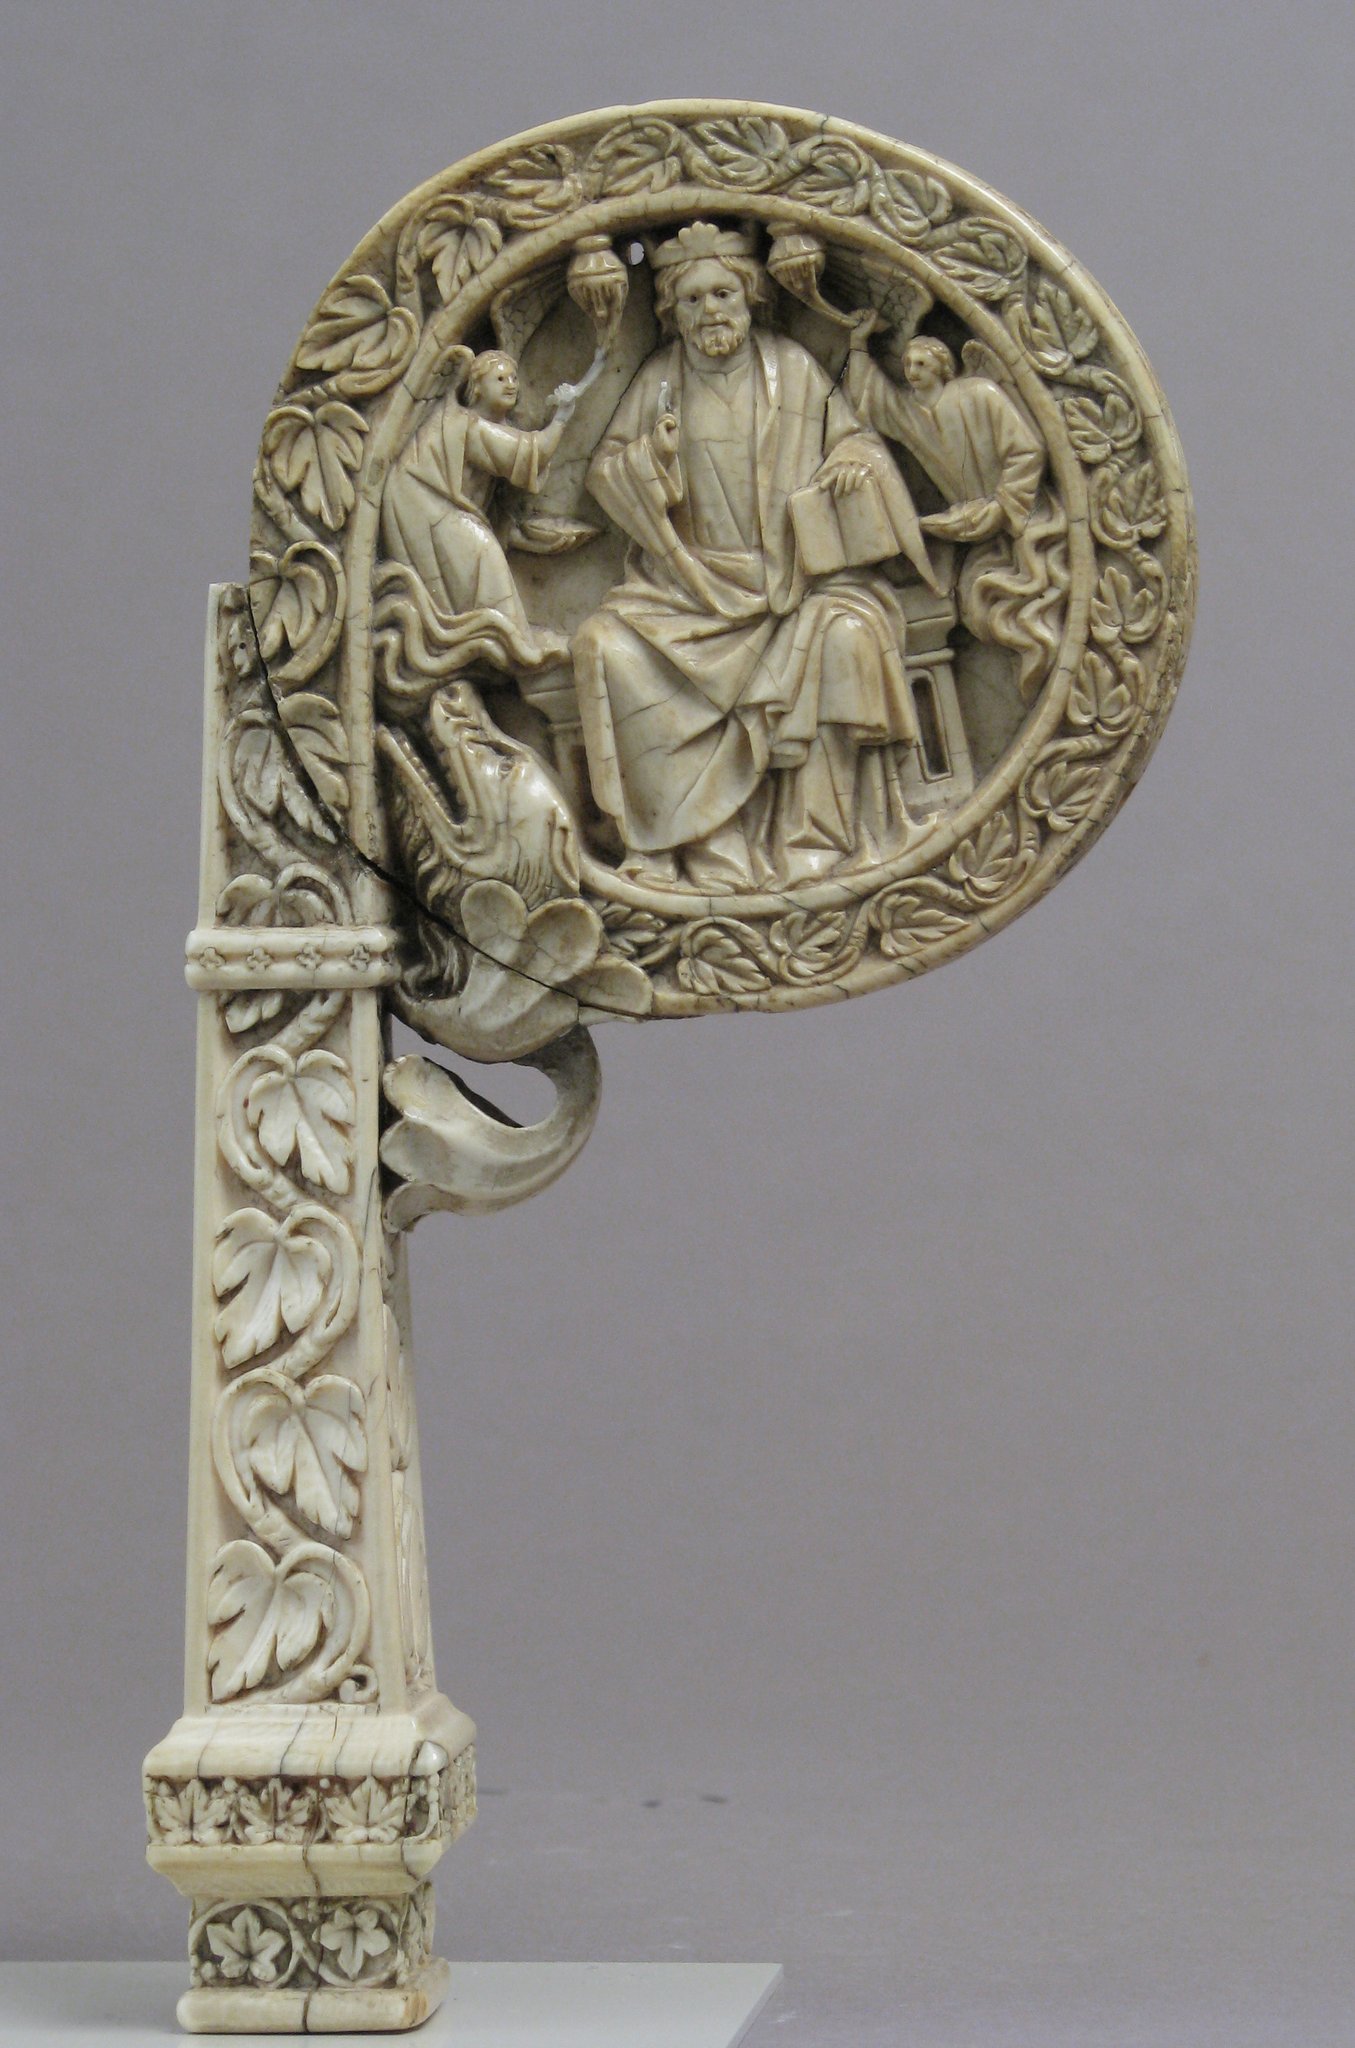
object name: crozier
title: Ivory Crozier Head with Christ in Majesty and Throne of Wisdom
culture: german or italian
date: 1201-1300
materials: ivory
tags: angels,christ